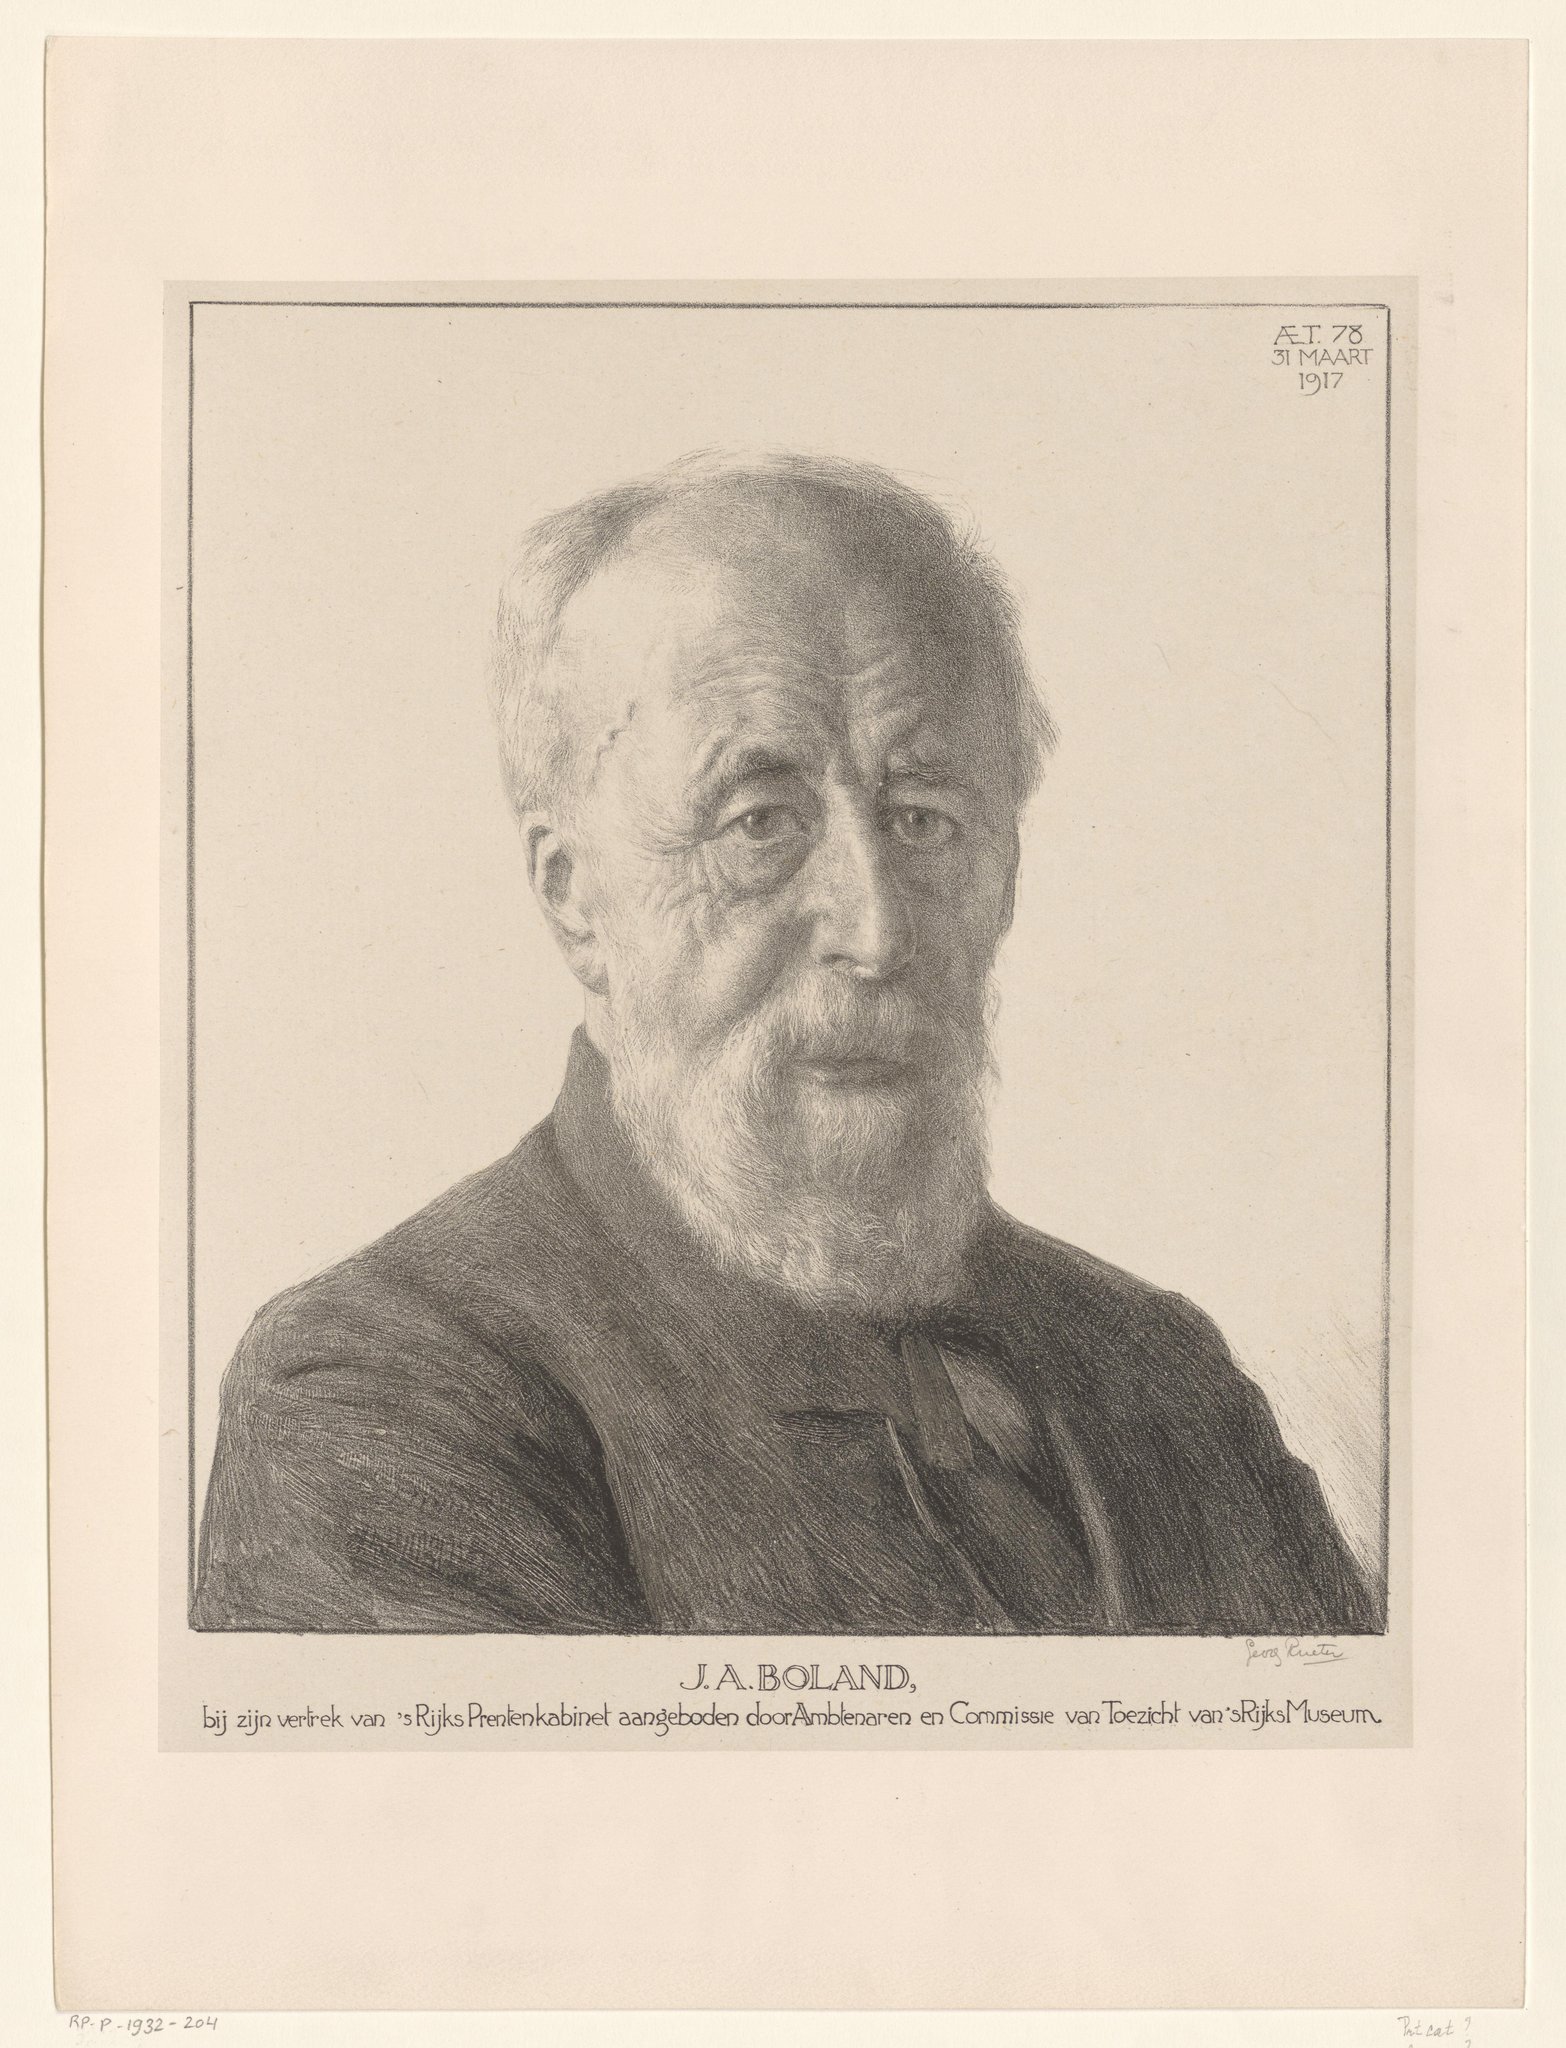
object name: print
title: J.A. Boland bij zijn vertrek van 's Rijks Prentenkabinet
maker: georg rueter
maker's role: draughtsman, painter, print maker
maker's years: 1875-1966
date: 1917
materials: paper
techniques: lithograph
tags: amsterdam, print maker, johannes arnoldus boland, historical persons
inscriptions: date